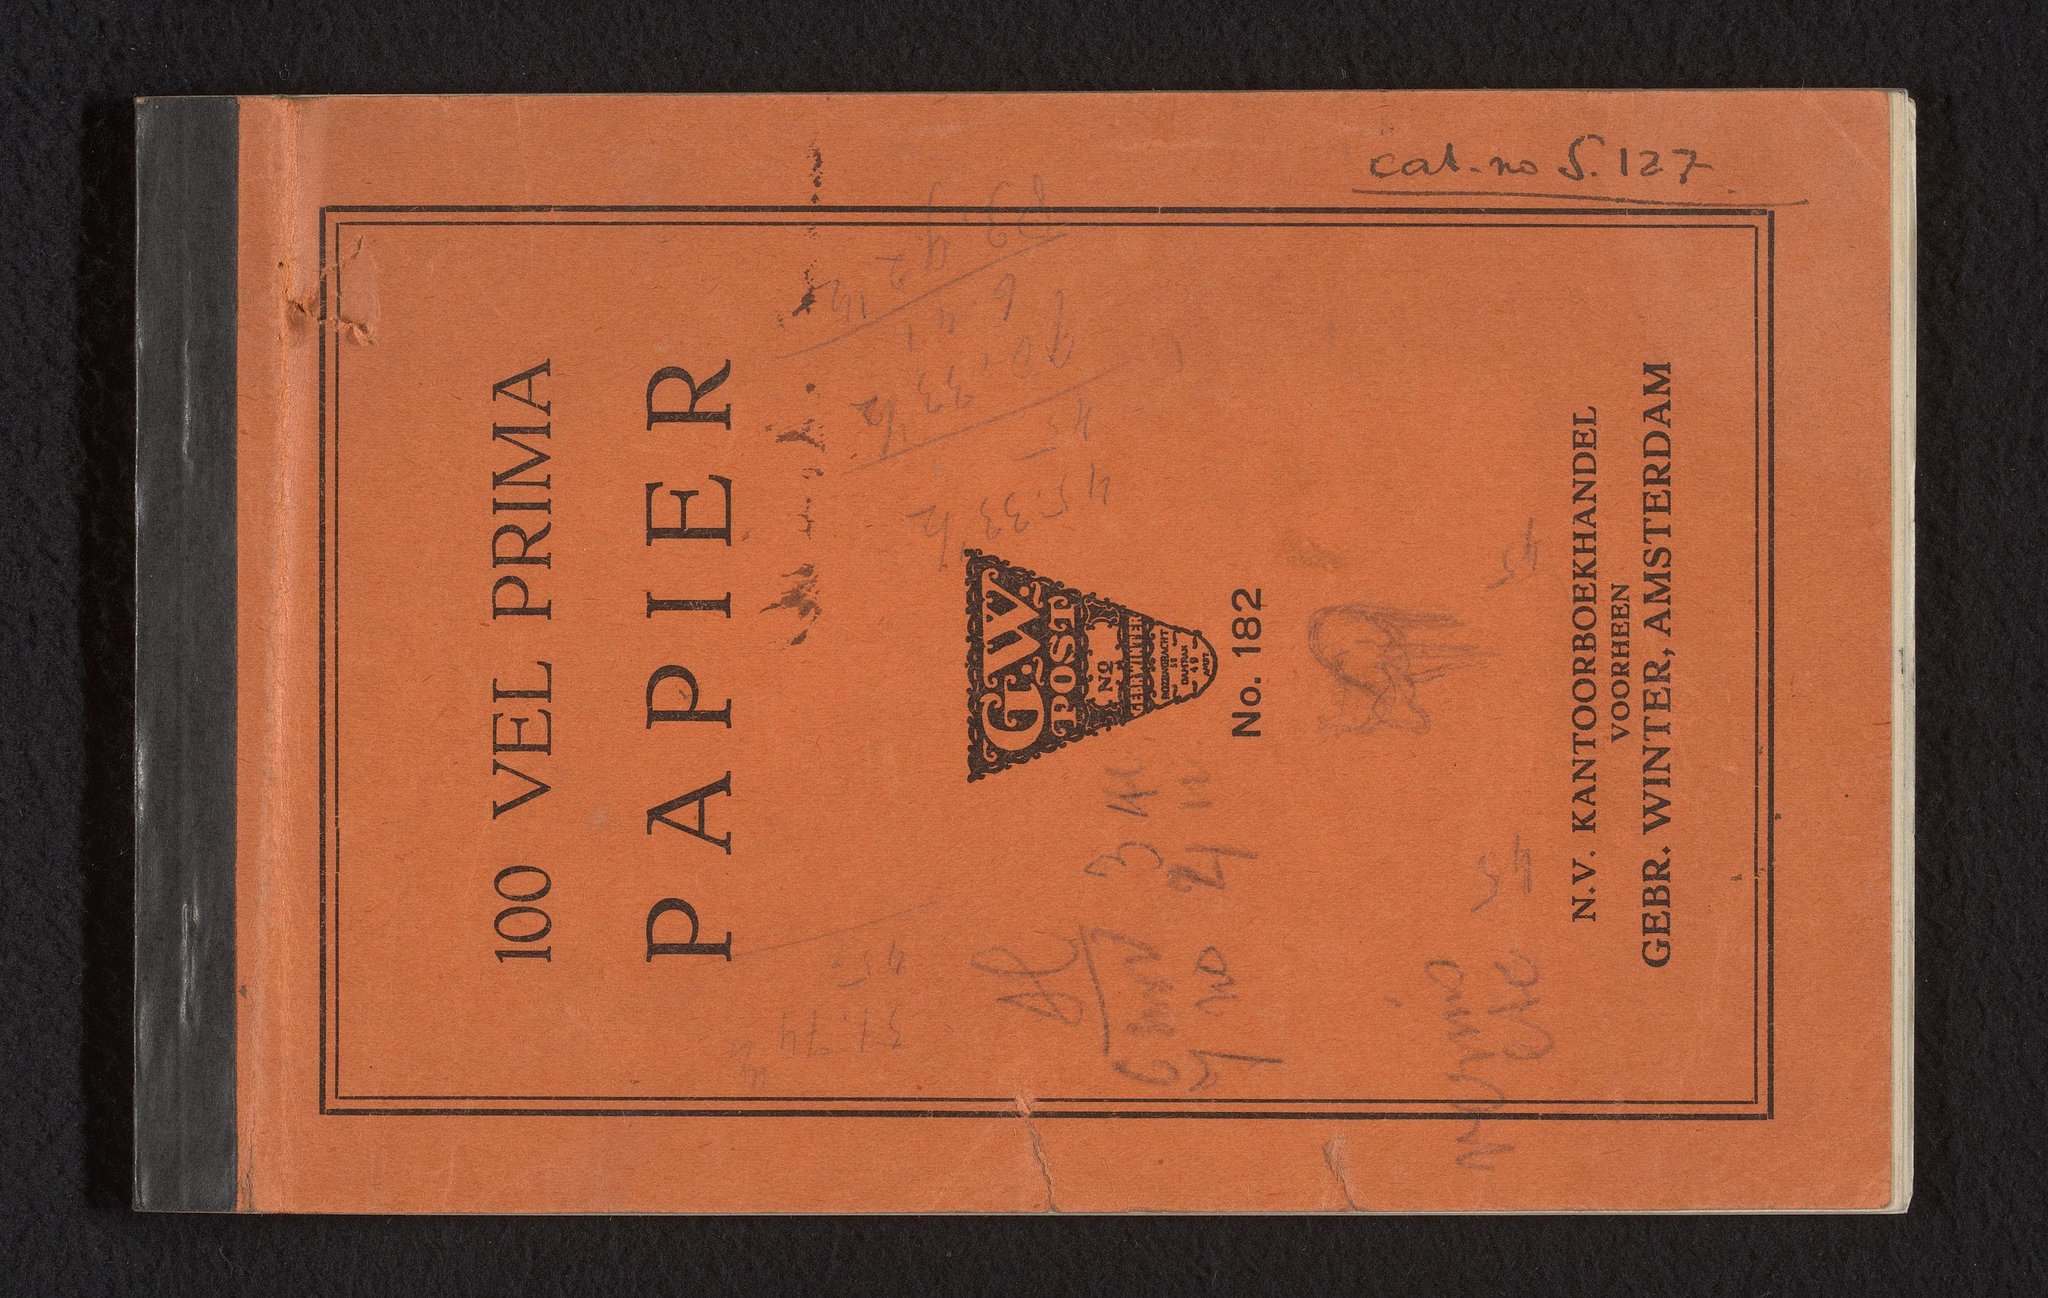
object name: sketchbook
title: Schetsboek met Ex Libris ontwerpen voor MCS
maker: leo gestel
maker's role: draughtsman, print maker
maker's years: 1881-1941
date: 1939-1941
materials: ink, paper, pencil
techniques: brush, drawing, pen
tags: print maker, draughtsman, leo gestel, ex-libris, portrait, self-portrait of artist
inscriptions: workshop stamp: Lugt 1078a, inscription: ‘schetsboek/ (...) 35 bladen’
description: Schetsboek met ontwerpen van ex-librissen, met: zelfportret (karikatuur), naakten, paarden, gevleugelde paarden, paard met man en zeemeerminnen.